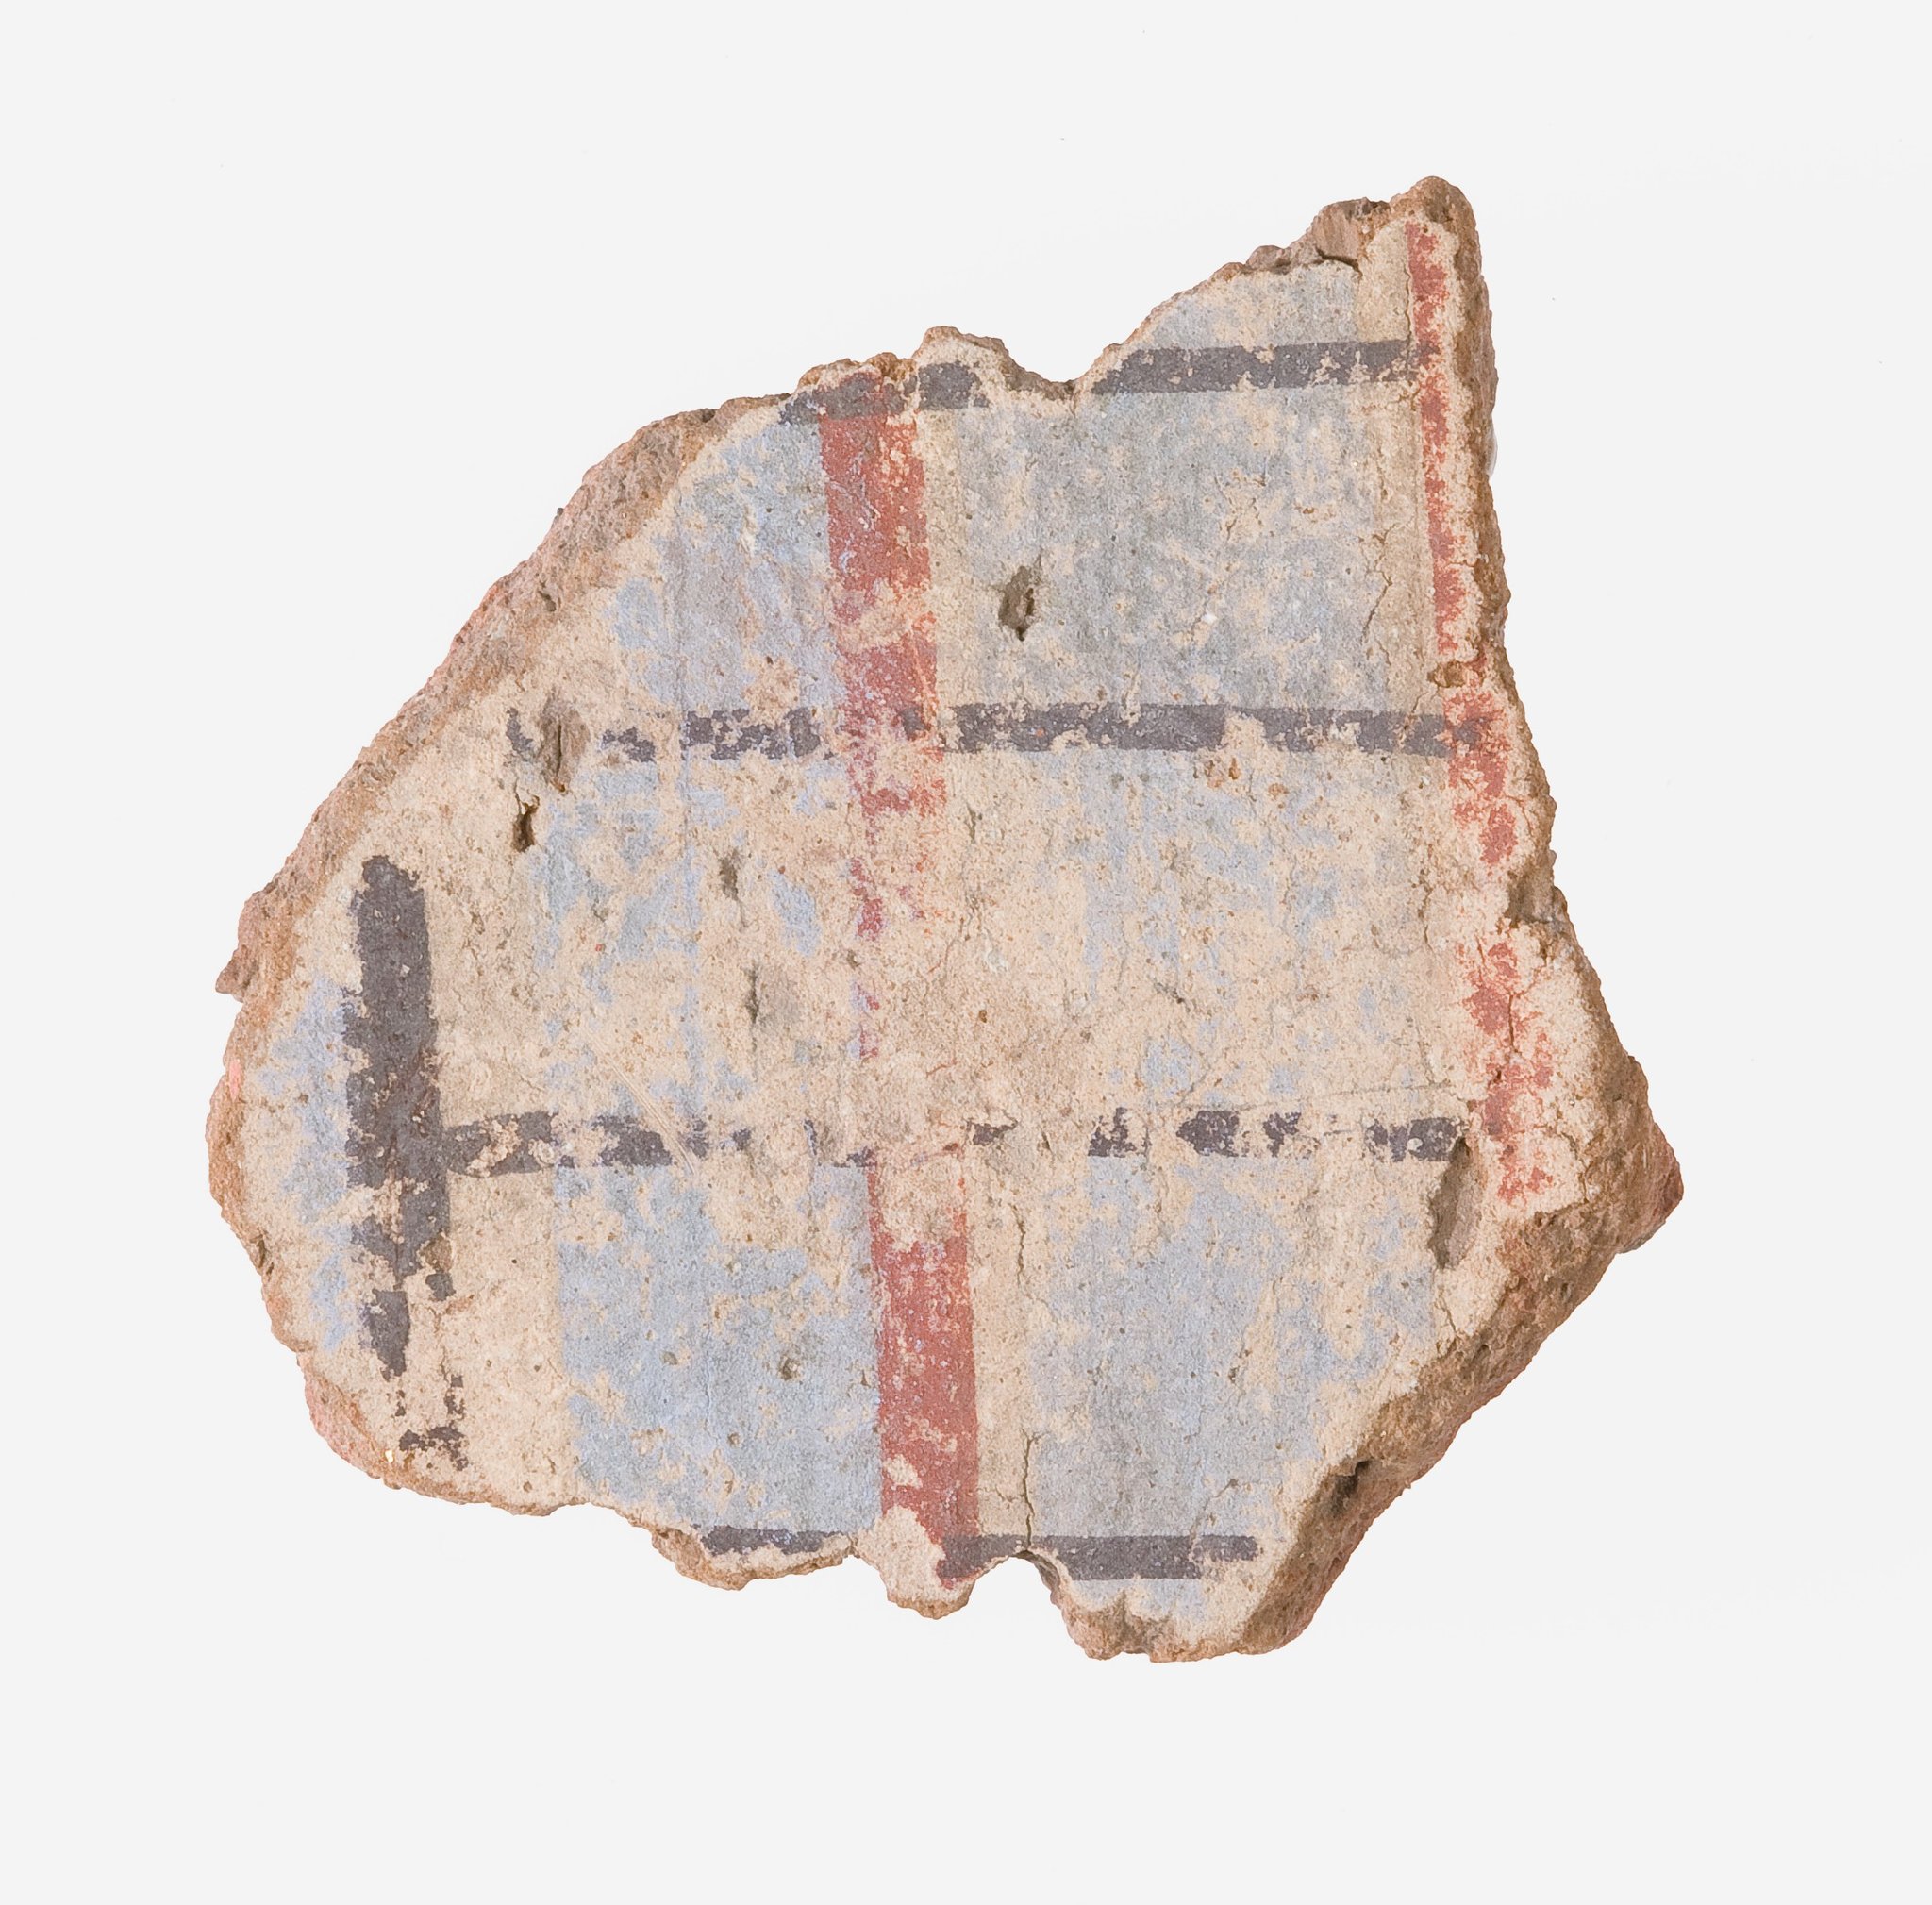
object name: vessel fragment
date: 1390-1352 BCE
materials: paint, pottery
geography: egypt